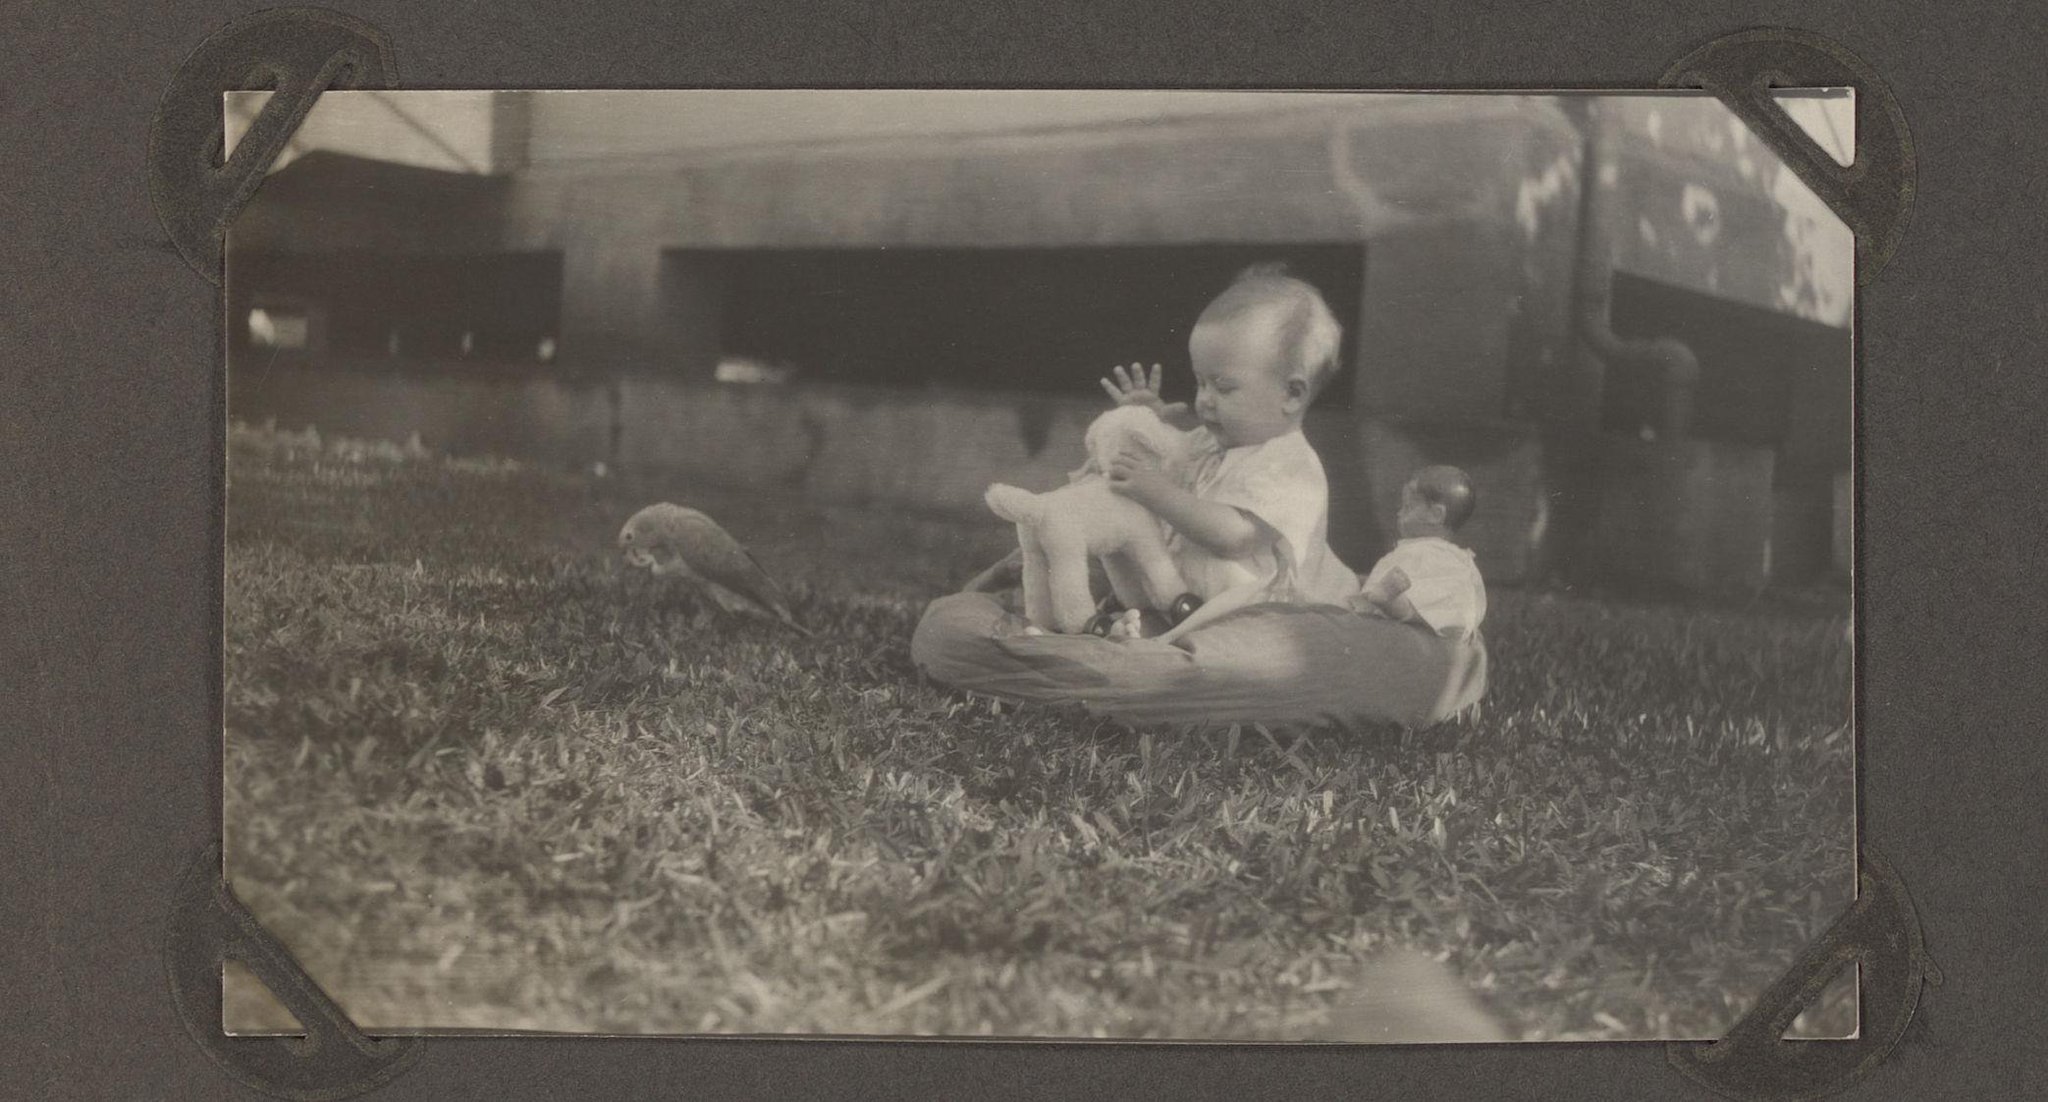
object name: photograph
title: Familiefoto van het gezin Jetten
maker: Anonymous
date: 1925-1927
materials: photographic support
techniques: photography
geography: suriname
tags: jetten, familie, moengo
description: Familiefoto van de kinderen Jetten met de ouders. Foto op een bladzijde van een los albumblad. Onderdeel van het ensemble met foto's van de familie van ingenieur Jetten in de mijnbouwstad Moengo in Suriname.